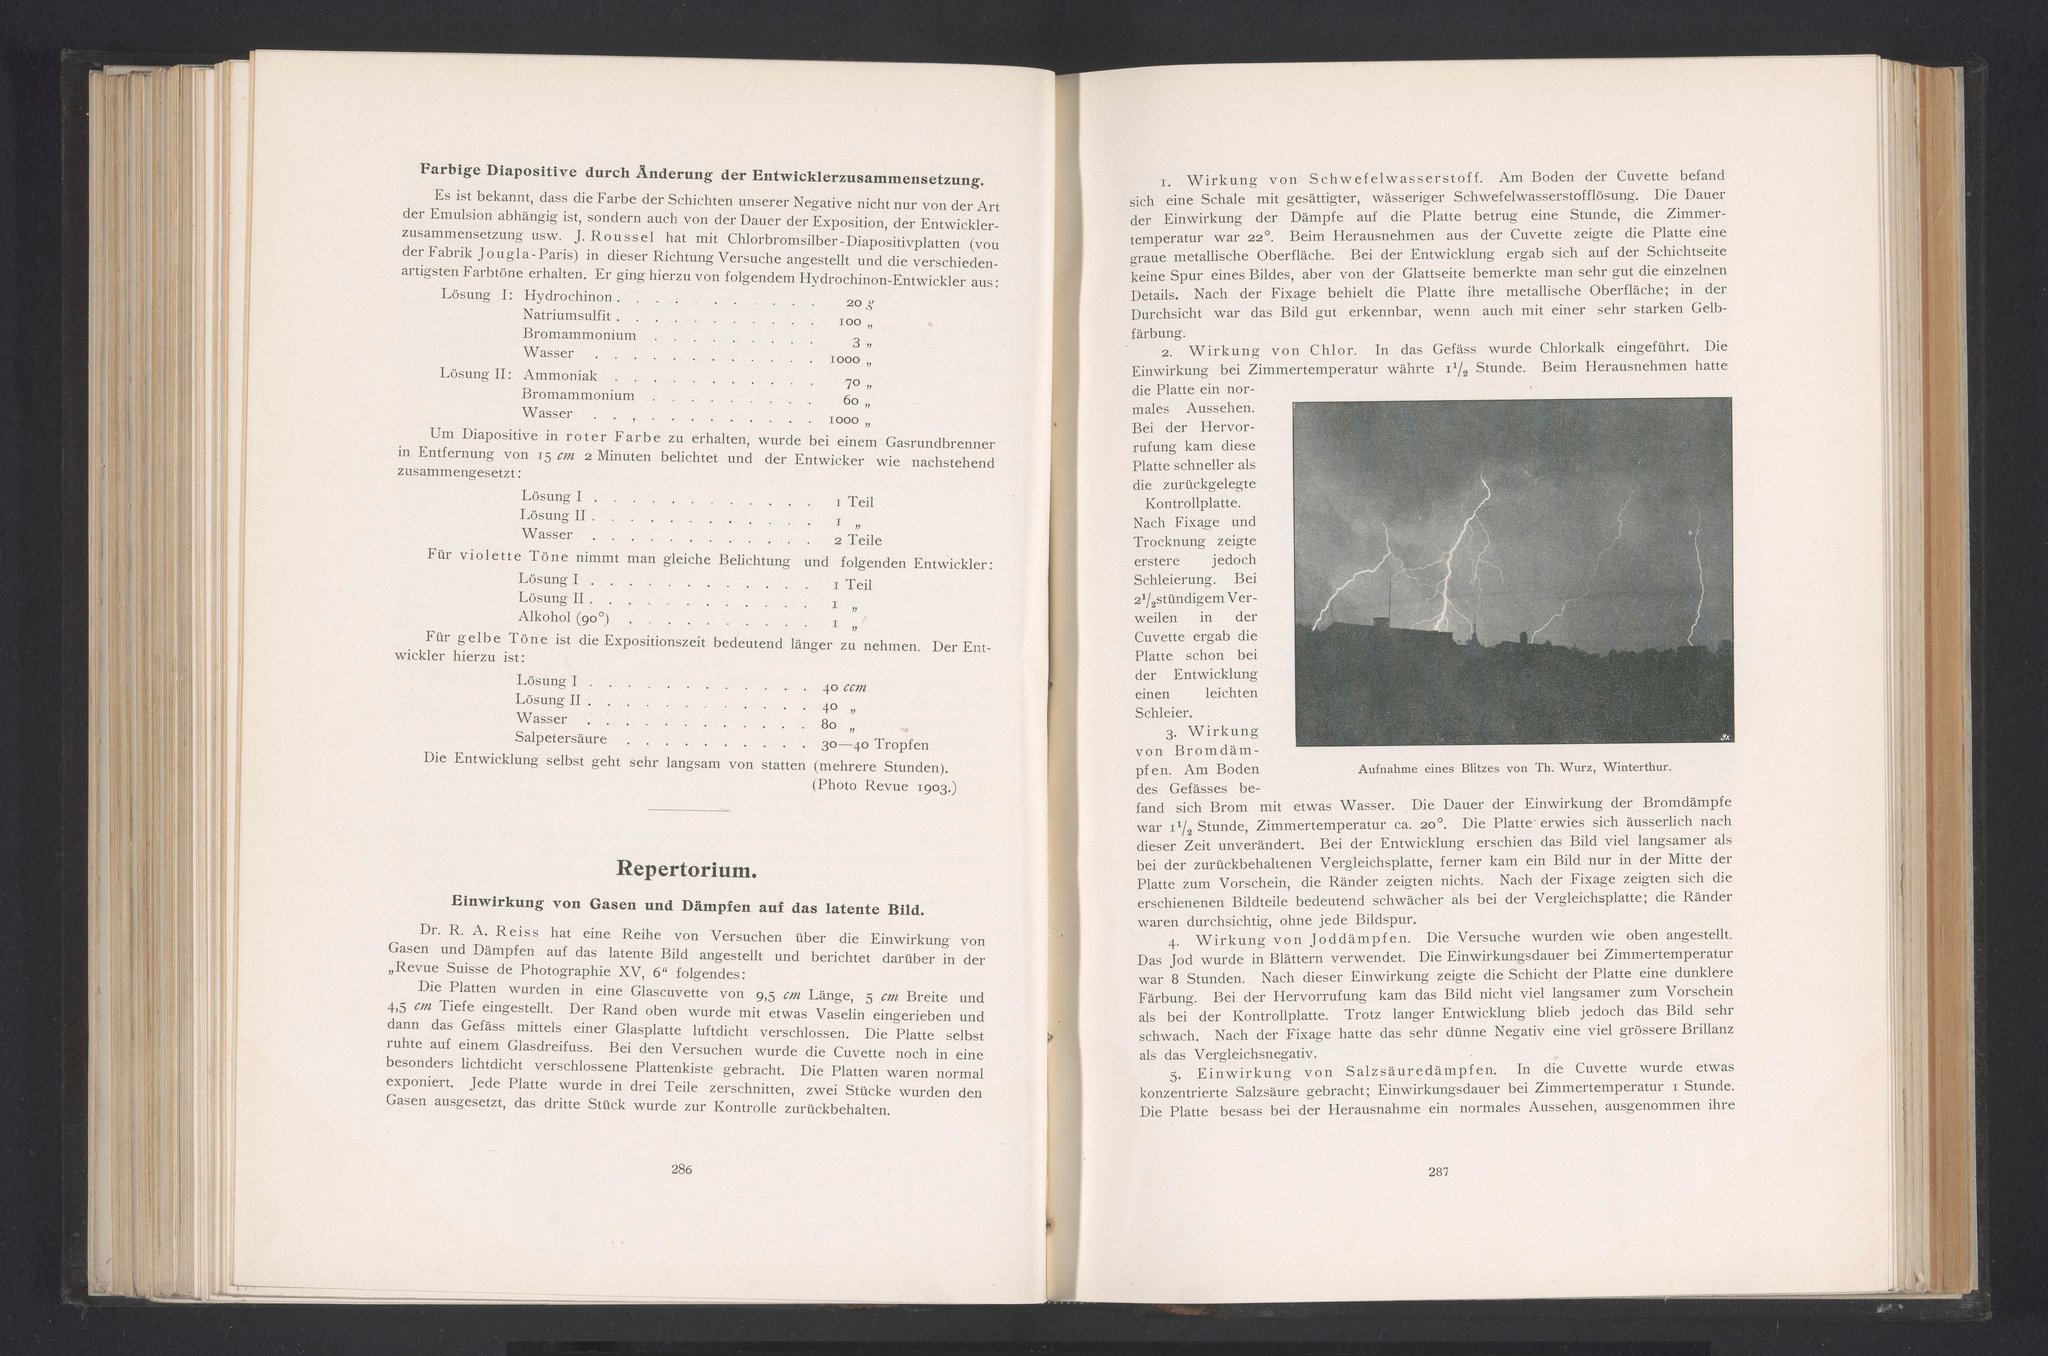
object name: photomechanical print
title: Aufnahme enies Blitzes vor Th. Wurz, Winterthur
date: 1898-1903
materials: paper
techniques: autotype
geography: winterthur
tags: city-view in general; 'veduta', lightning, flash of lightning, thunderbolt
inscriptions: monogram: ‘BX’